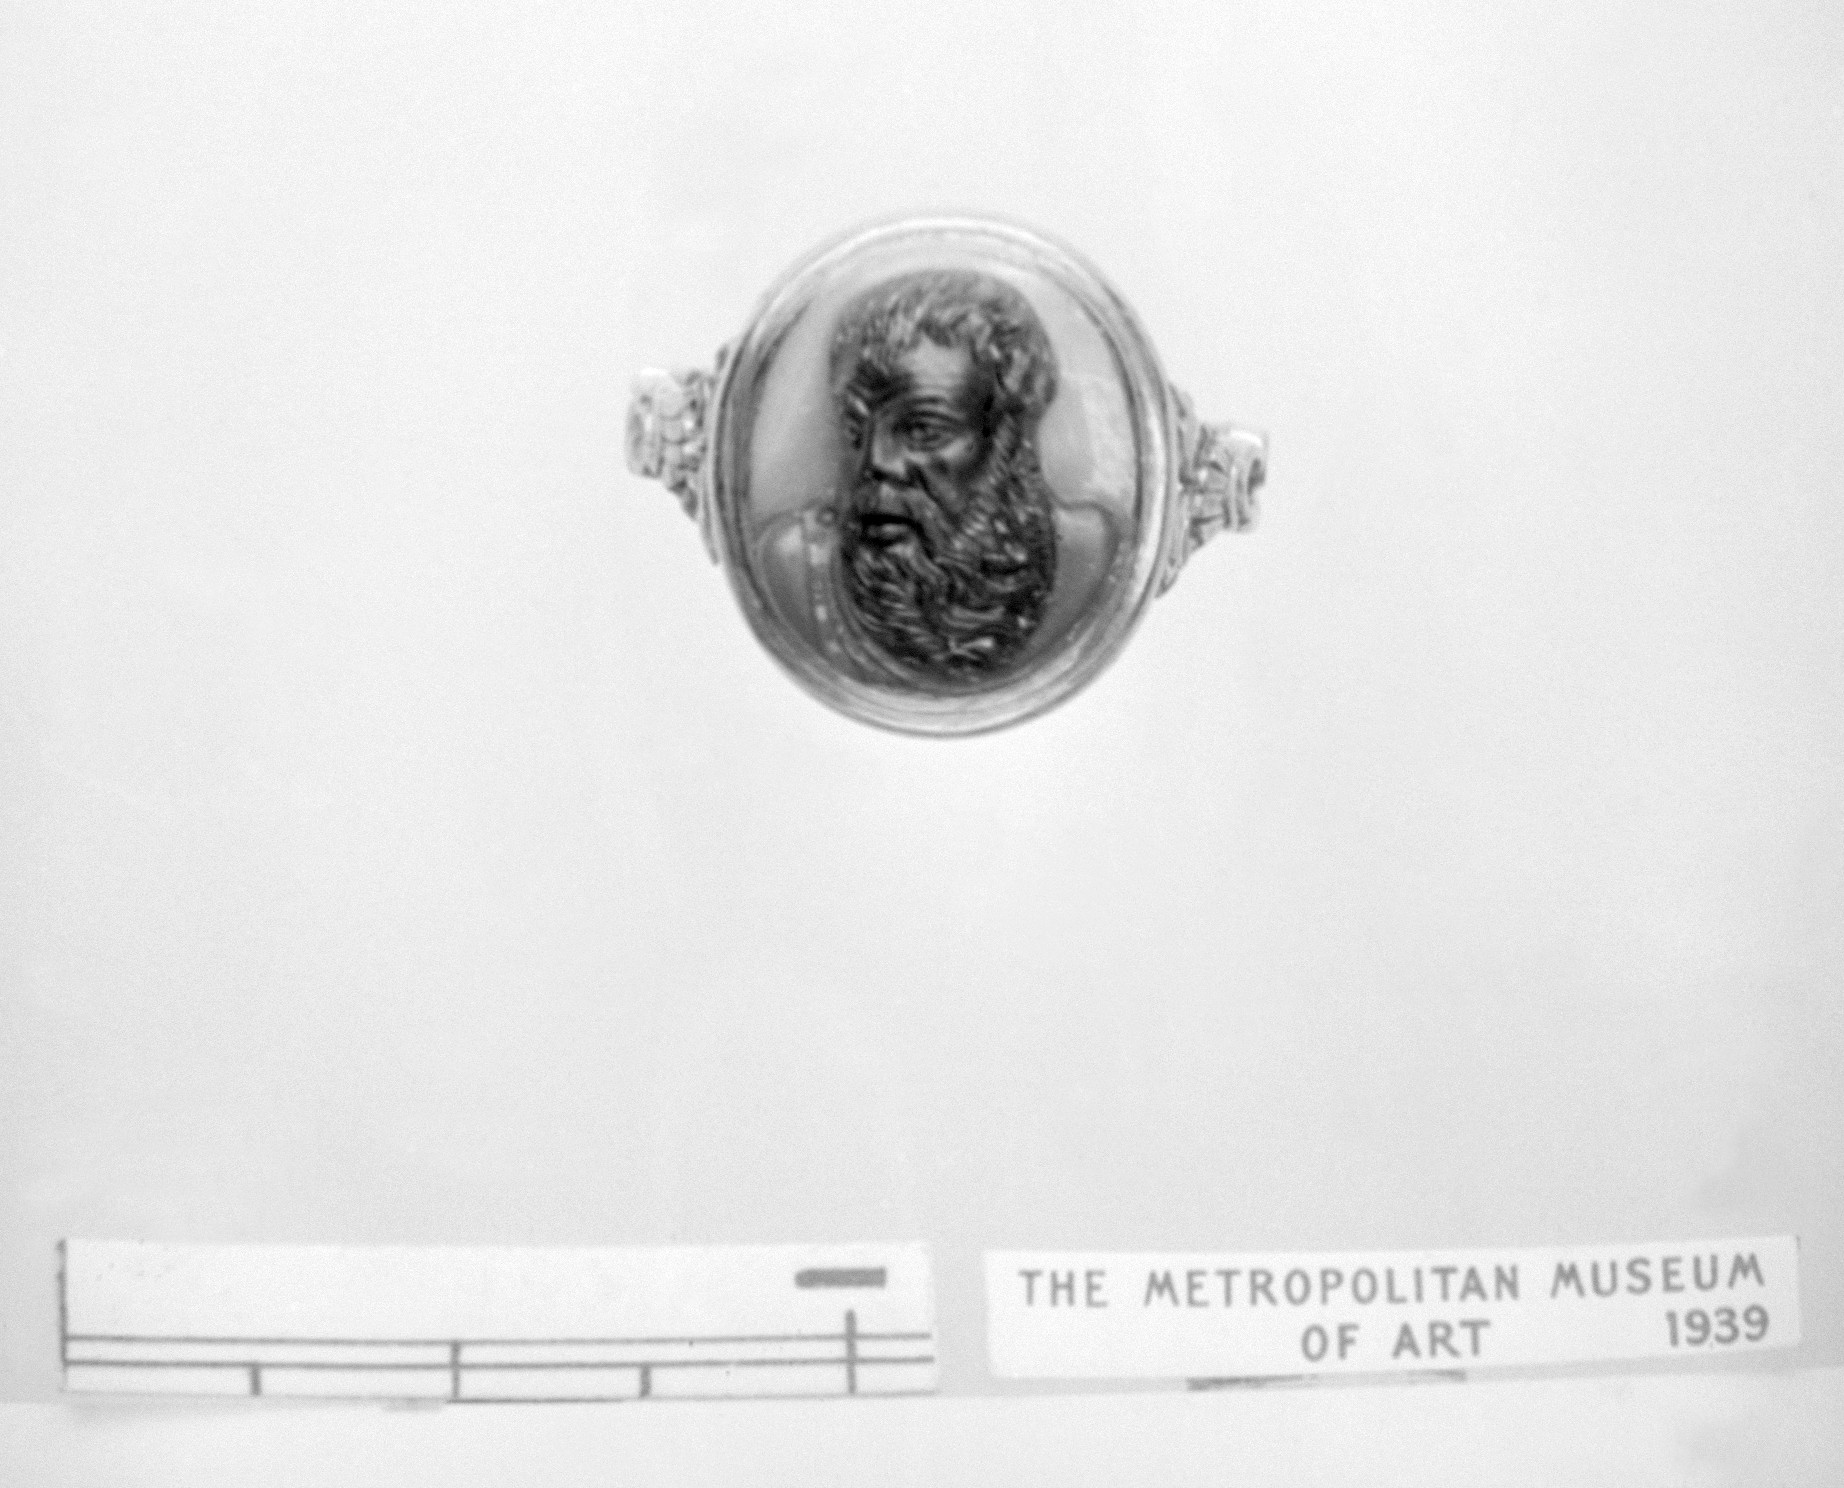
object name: cameo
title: Pietro Aretino (1492–1556)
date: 1734-1766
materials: gold, gemstone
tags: men,portraits